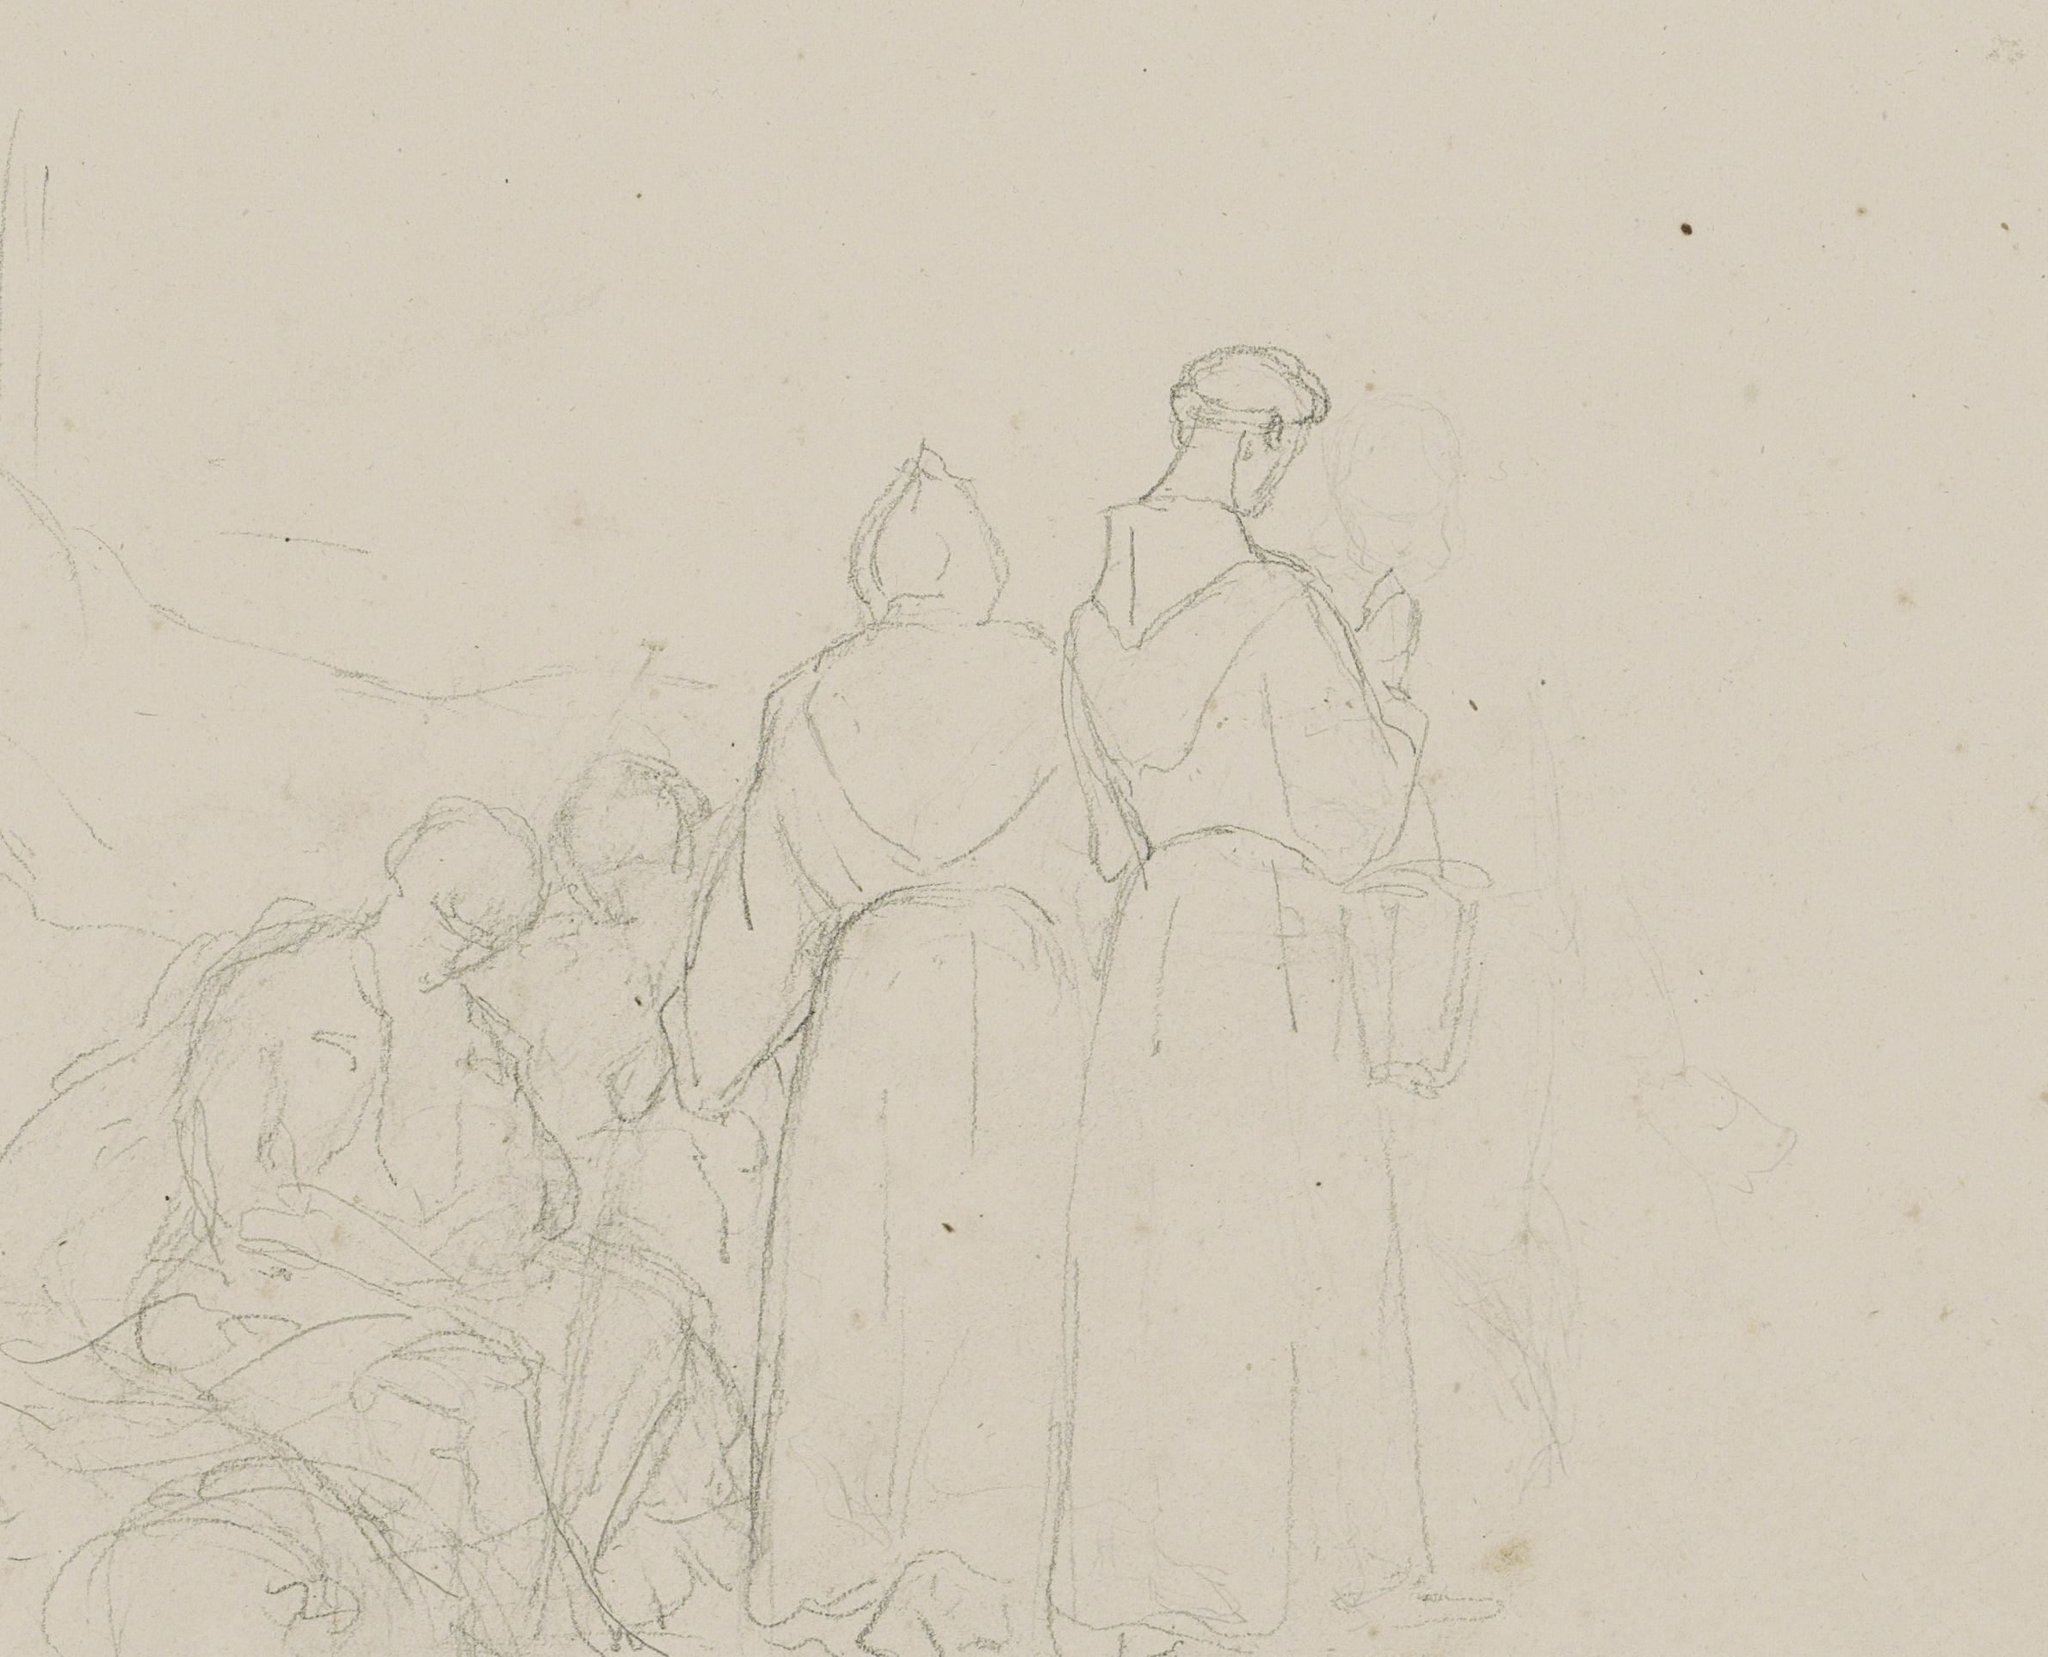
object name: sketchbook leaf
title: Twee monniken op een pad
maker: gerrit postma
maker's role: draughtsman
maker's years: 1819-1894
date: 1829-1894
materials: paper, pencil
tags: sitting figure, fence, wall, paling, monk(s), friar(s)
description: De monniken lopen voorbij twee figuren die langs de weg zitten. Blad 21 verso uit een schetsboek met 35 bladen.